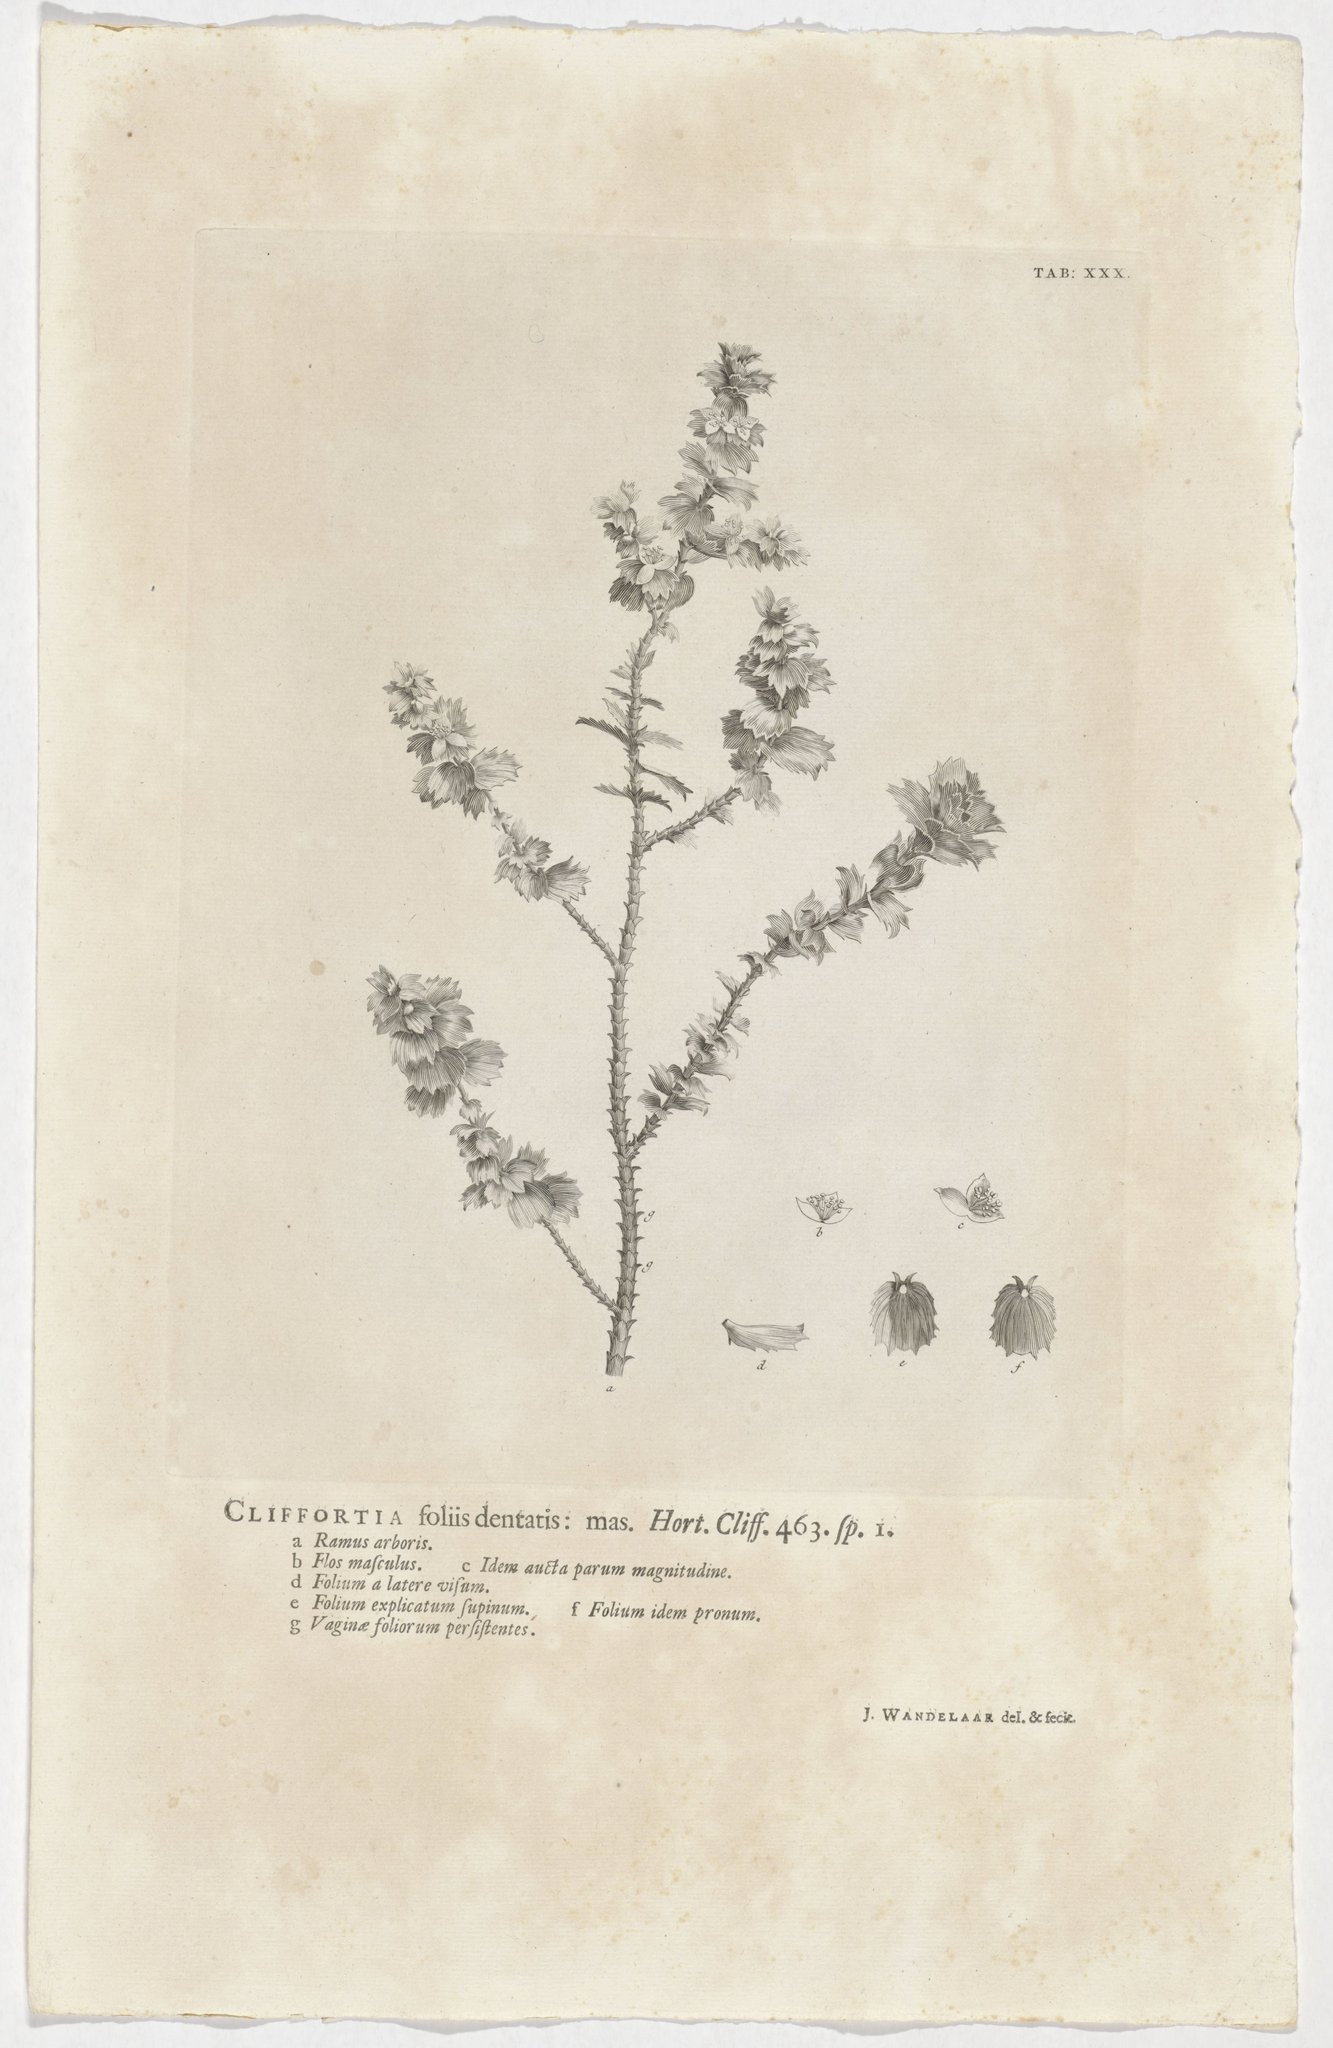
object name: print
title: Cliffortia ilicifolia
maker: jan wandelaar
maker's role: draughtsman, print maker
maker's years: 1690-1759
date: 1738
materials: paper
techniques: etching, letterpress printing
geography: warmond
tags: flowers, plants and herbs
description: Prent gebruikt als illustratie in: Linnaeus, Carolus. Hortus Cliffortianus plantas exhibens quas in hortis tam vivis quam siccis, Hartecampi in Hollandia, coluit (...) Georgius Clifford. Amsterdam: sine nomen, 1738.